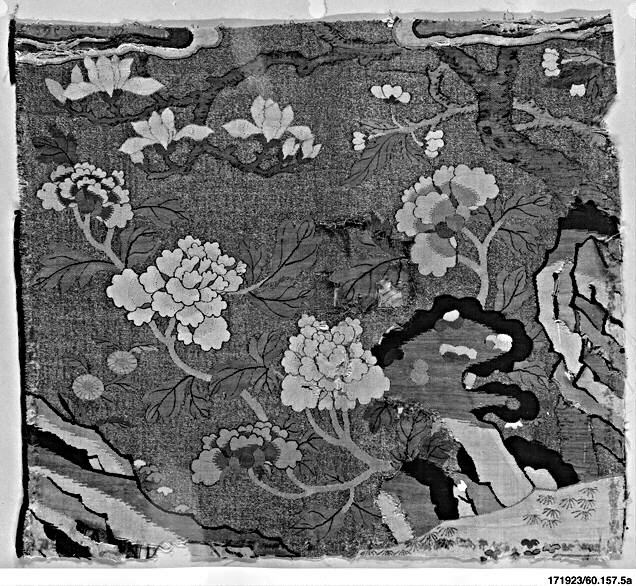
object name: piece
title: Panel with Peonies and Rocks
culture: chinese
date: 1701-1800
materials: metal thread, silk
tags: peonies